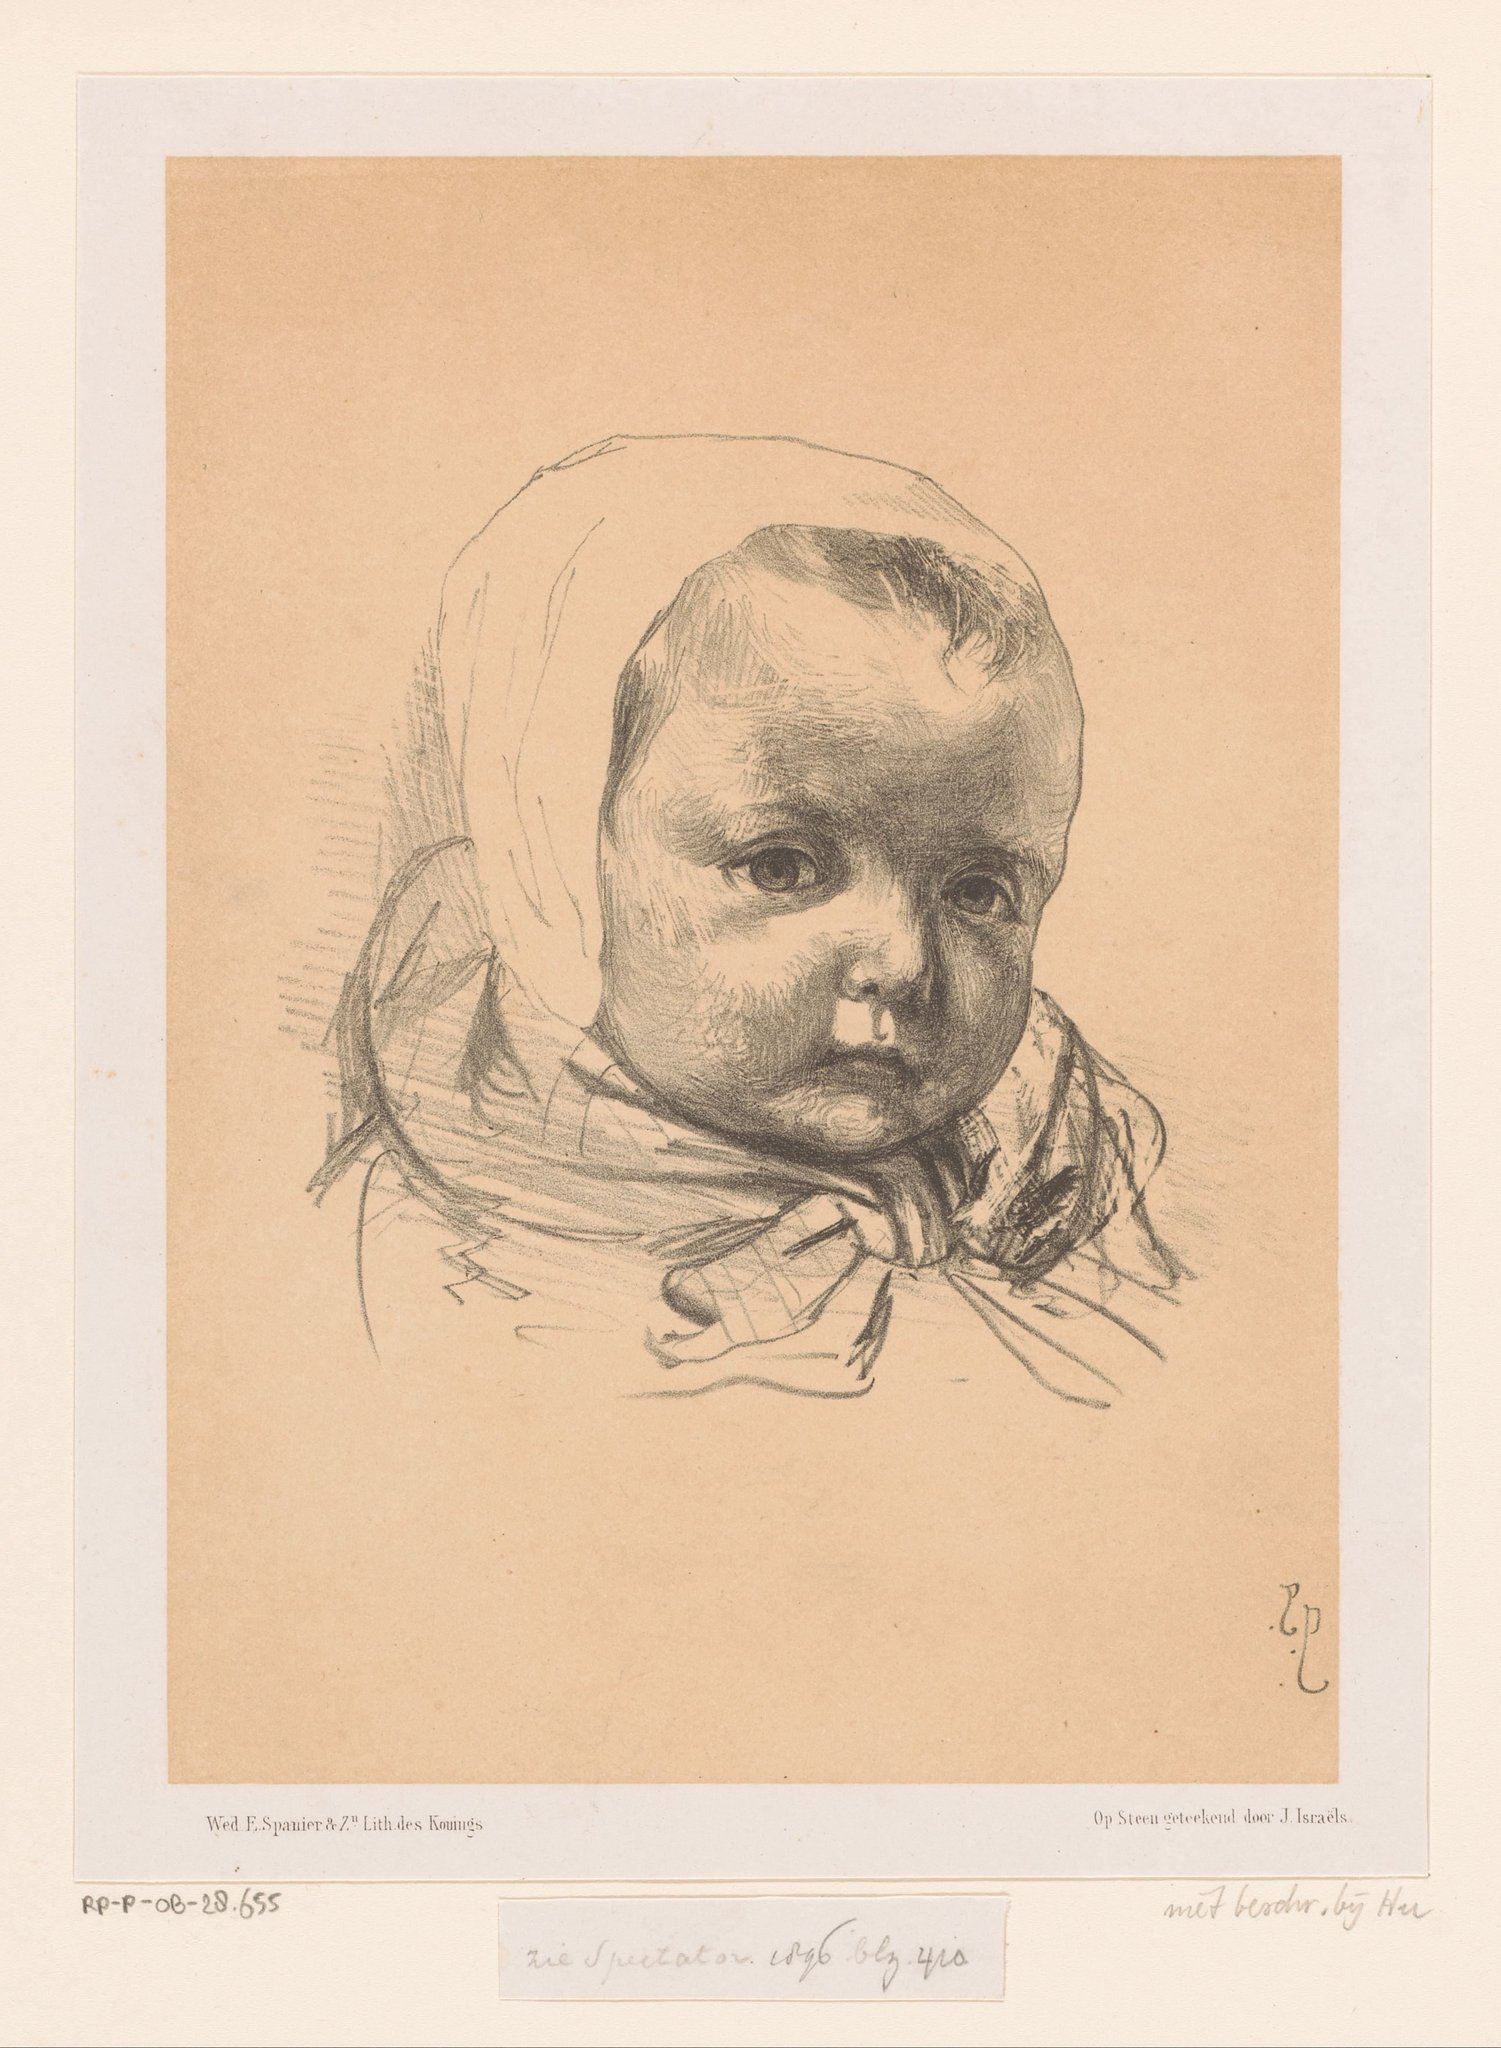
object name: print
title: Portret van een baby met muts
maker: jozef israëls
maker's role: draughtsman, painter, print maker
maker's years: 1824-1911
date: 1863-1883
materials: paper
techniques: tone lithography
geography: the hague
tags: historical persons (+ head (and shoulders) (portrait)), smoke-stack, head-gear: cap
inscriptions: collector's mark: Lugt 2228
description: Volgens een los bijschrift werd deze prent in 1896 uitgegeven door de Nederlandsche Spectator. Op een los bijschrift bij prent: RP-P-OB-28.656 (dezelfde voorstelling) wordt vermeldt dat deze prent werd uitgegeven bij het Album van de Nederlandsche Spectator in 1869.